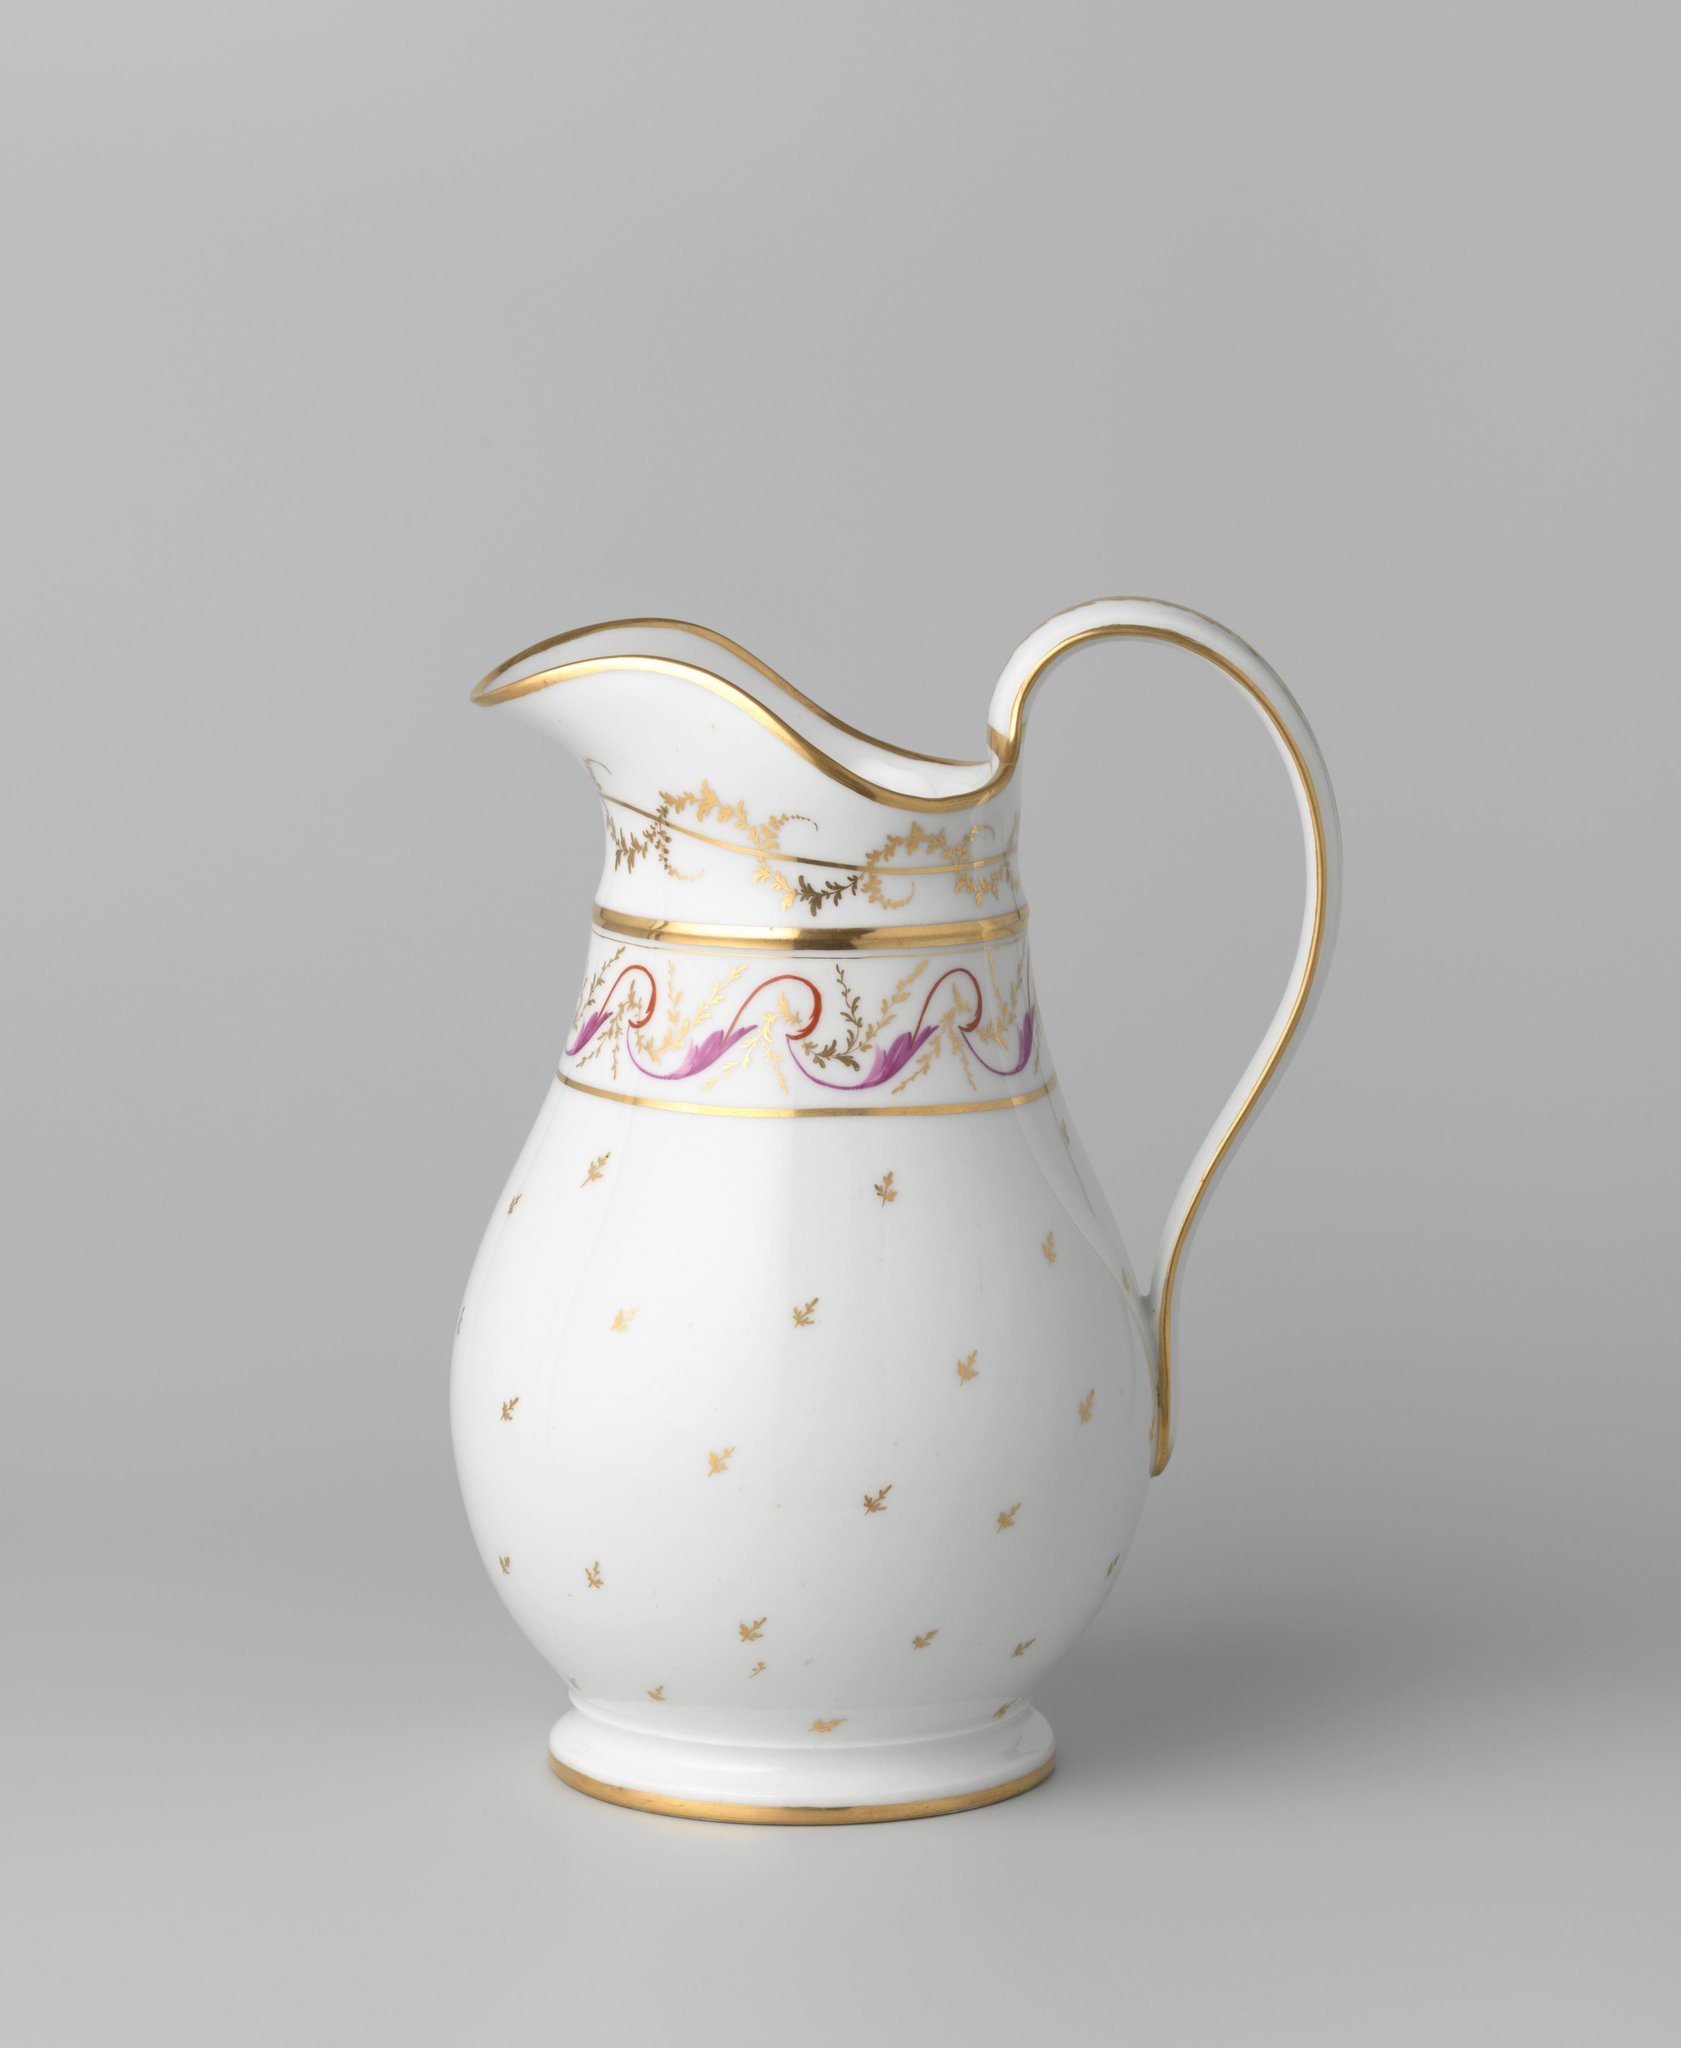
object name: pitcher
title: Ewer with floral scrolls and flower sprigs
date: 1775-1799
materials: glaze, gold, paint, porcelain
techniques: firing, forming, gilding, turning, vitrification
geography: paris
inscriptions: mark: ‘E.B.’, mark: ‘B Potter 23’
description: Kan (lampetkan) van porselein op een spreidende voet, met een peervormig lichaam, hoog oor en brede schenkrand. Beschilderd op het glazuur in rood, paars en goud. Op de buik strooibloemen. De nek met een band van gouden lijnen met daarin een bloemrank. Onder de rand een bladrank golvend om een gouden lijn. Bladrank op het oor en gouden banden op de voet en de rand. Gemerkt op de onderzijde met 'B Potter 23' en E.B.